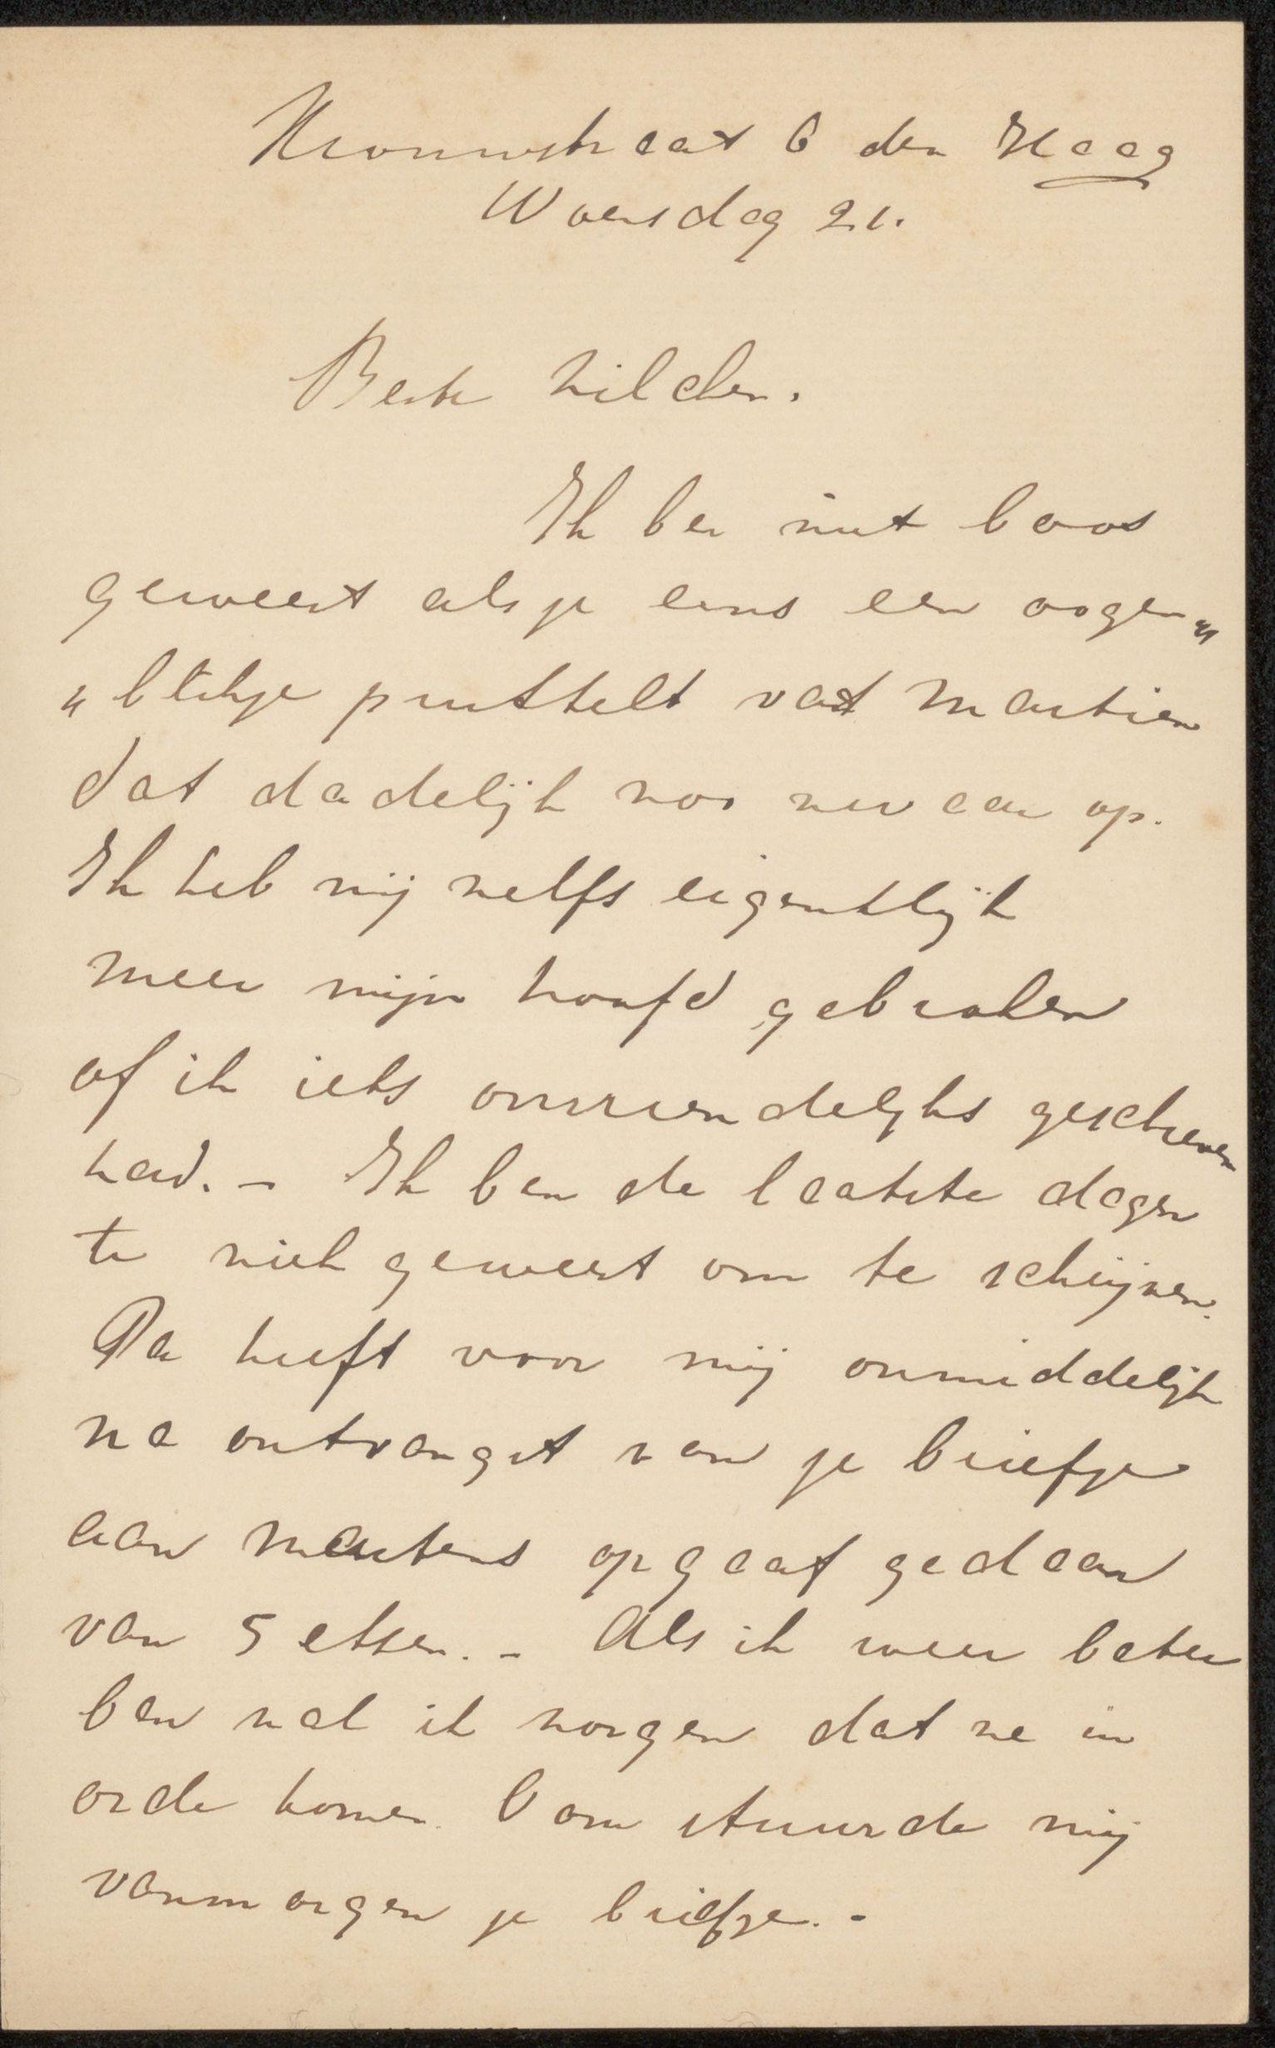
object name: letter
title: Brief aan Philip Zilcken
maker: barbara elisabeth van houten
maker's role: draughtsman, print maker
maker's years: 1862-1950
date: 1900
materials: ink, paper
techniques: pen, writing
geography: the hague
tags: painter, draughtsman, philip zilcken, the graphic arts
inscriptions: watermark, collector's mark: ‘RPK’